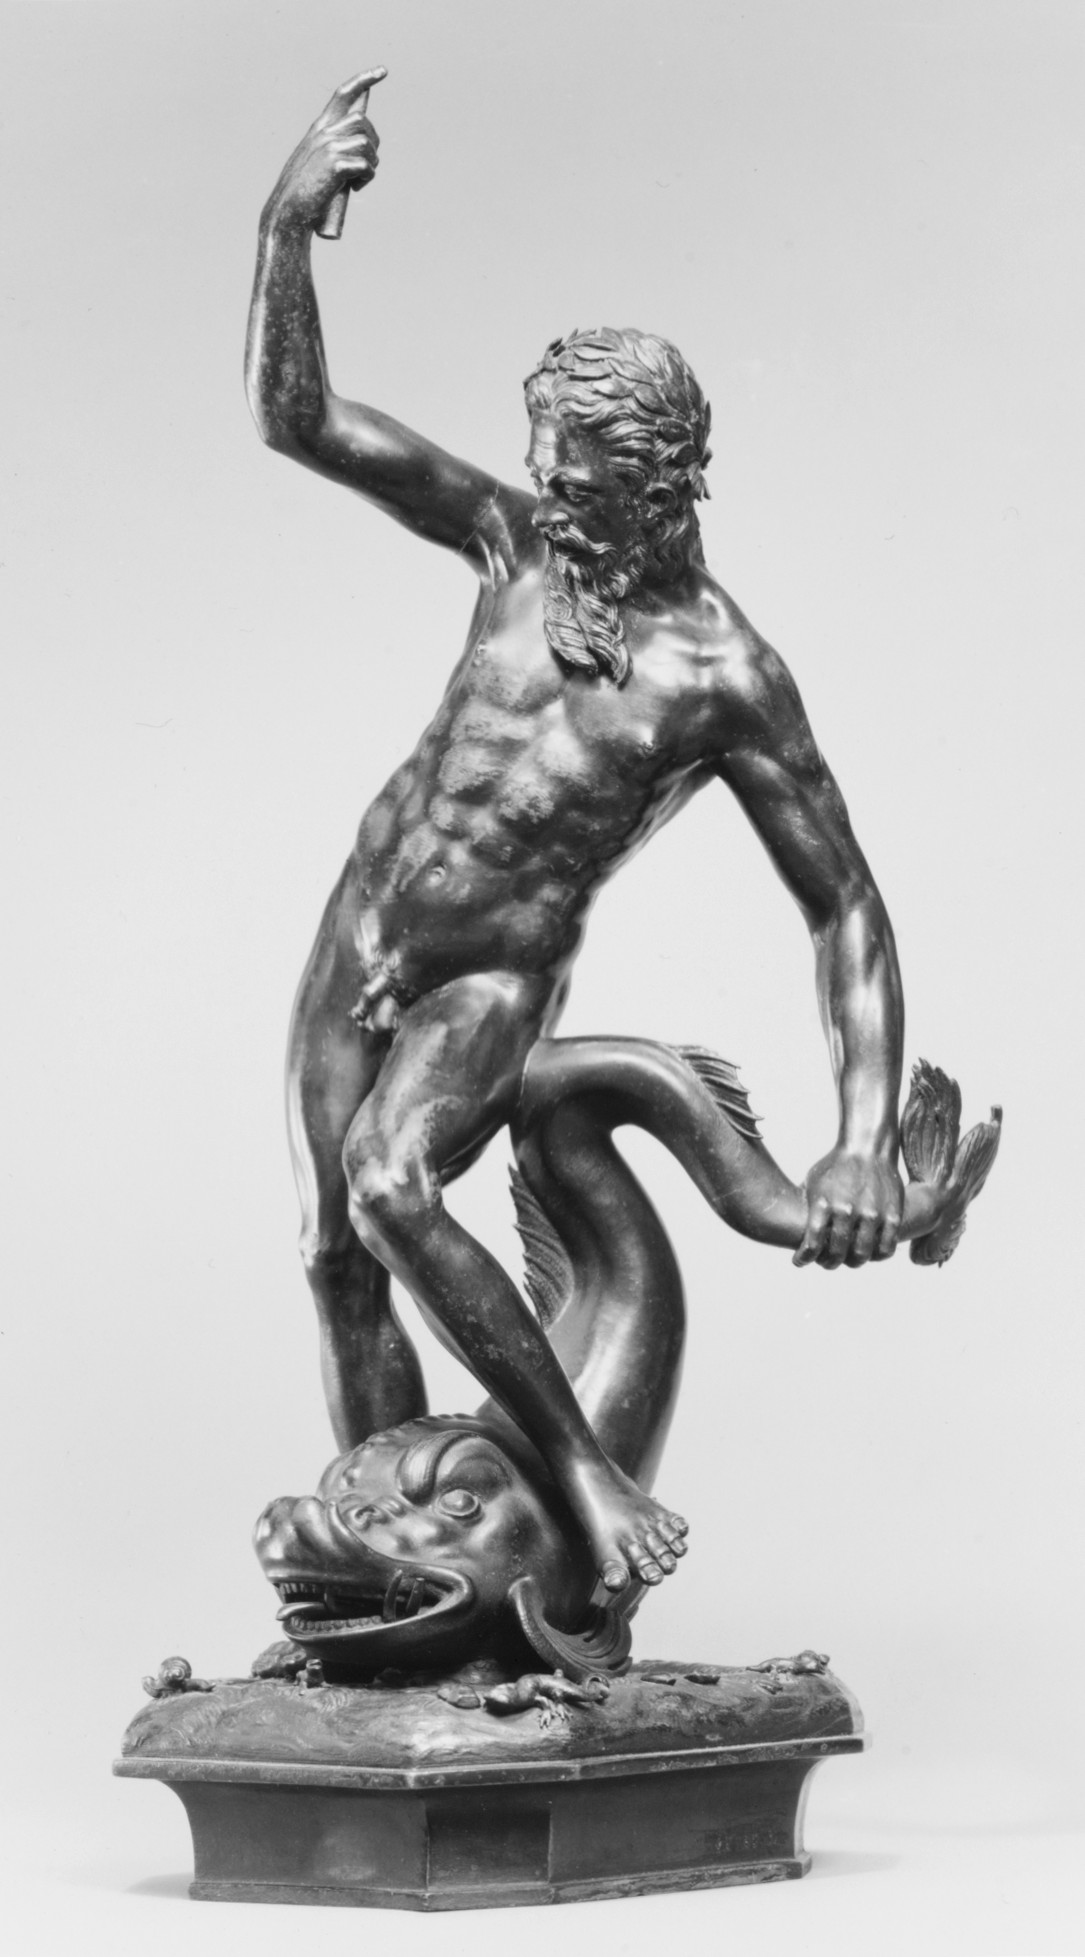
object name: statuette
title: Neptune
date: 1601-1633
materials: bronze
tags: neptune,dolphins